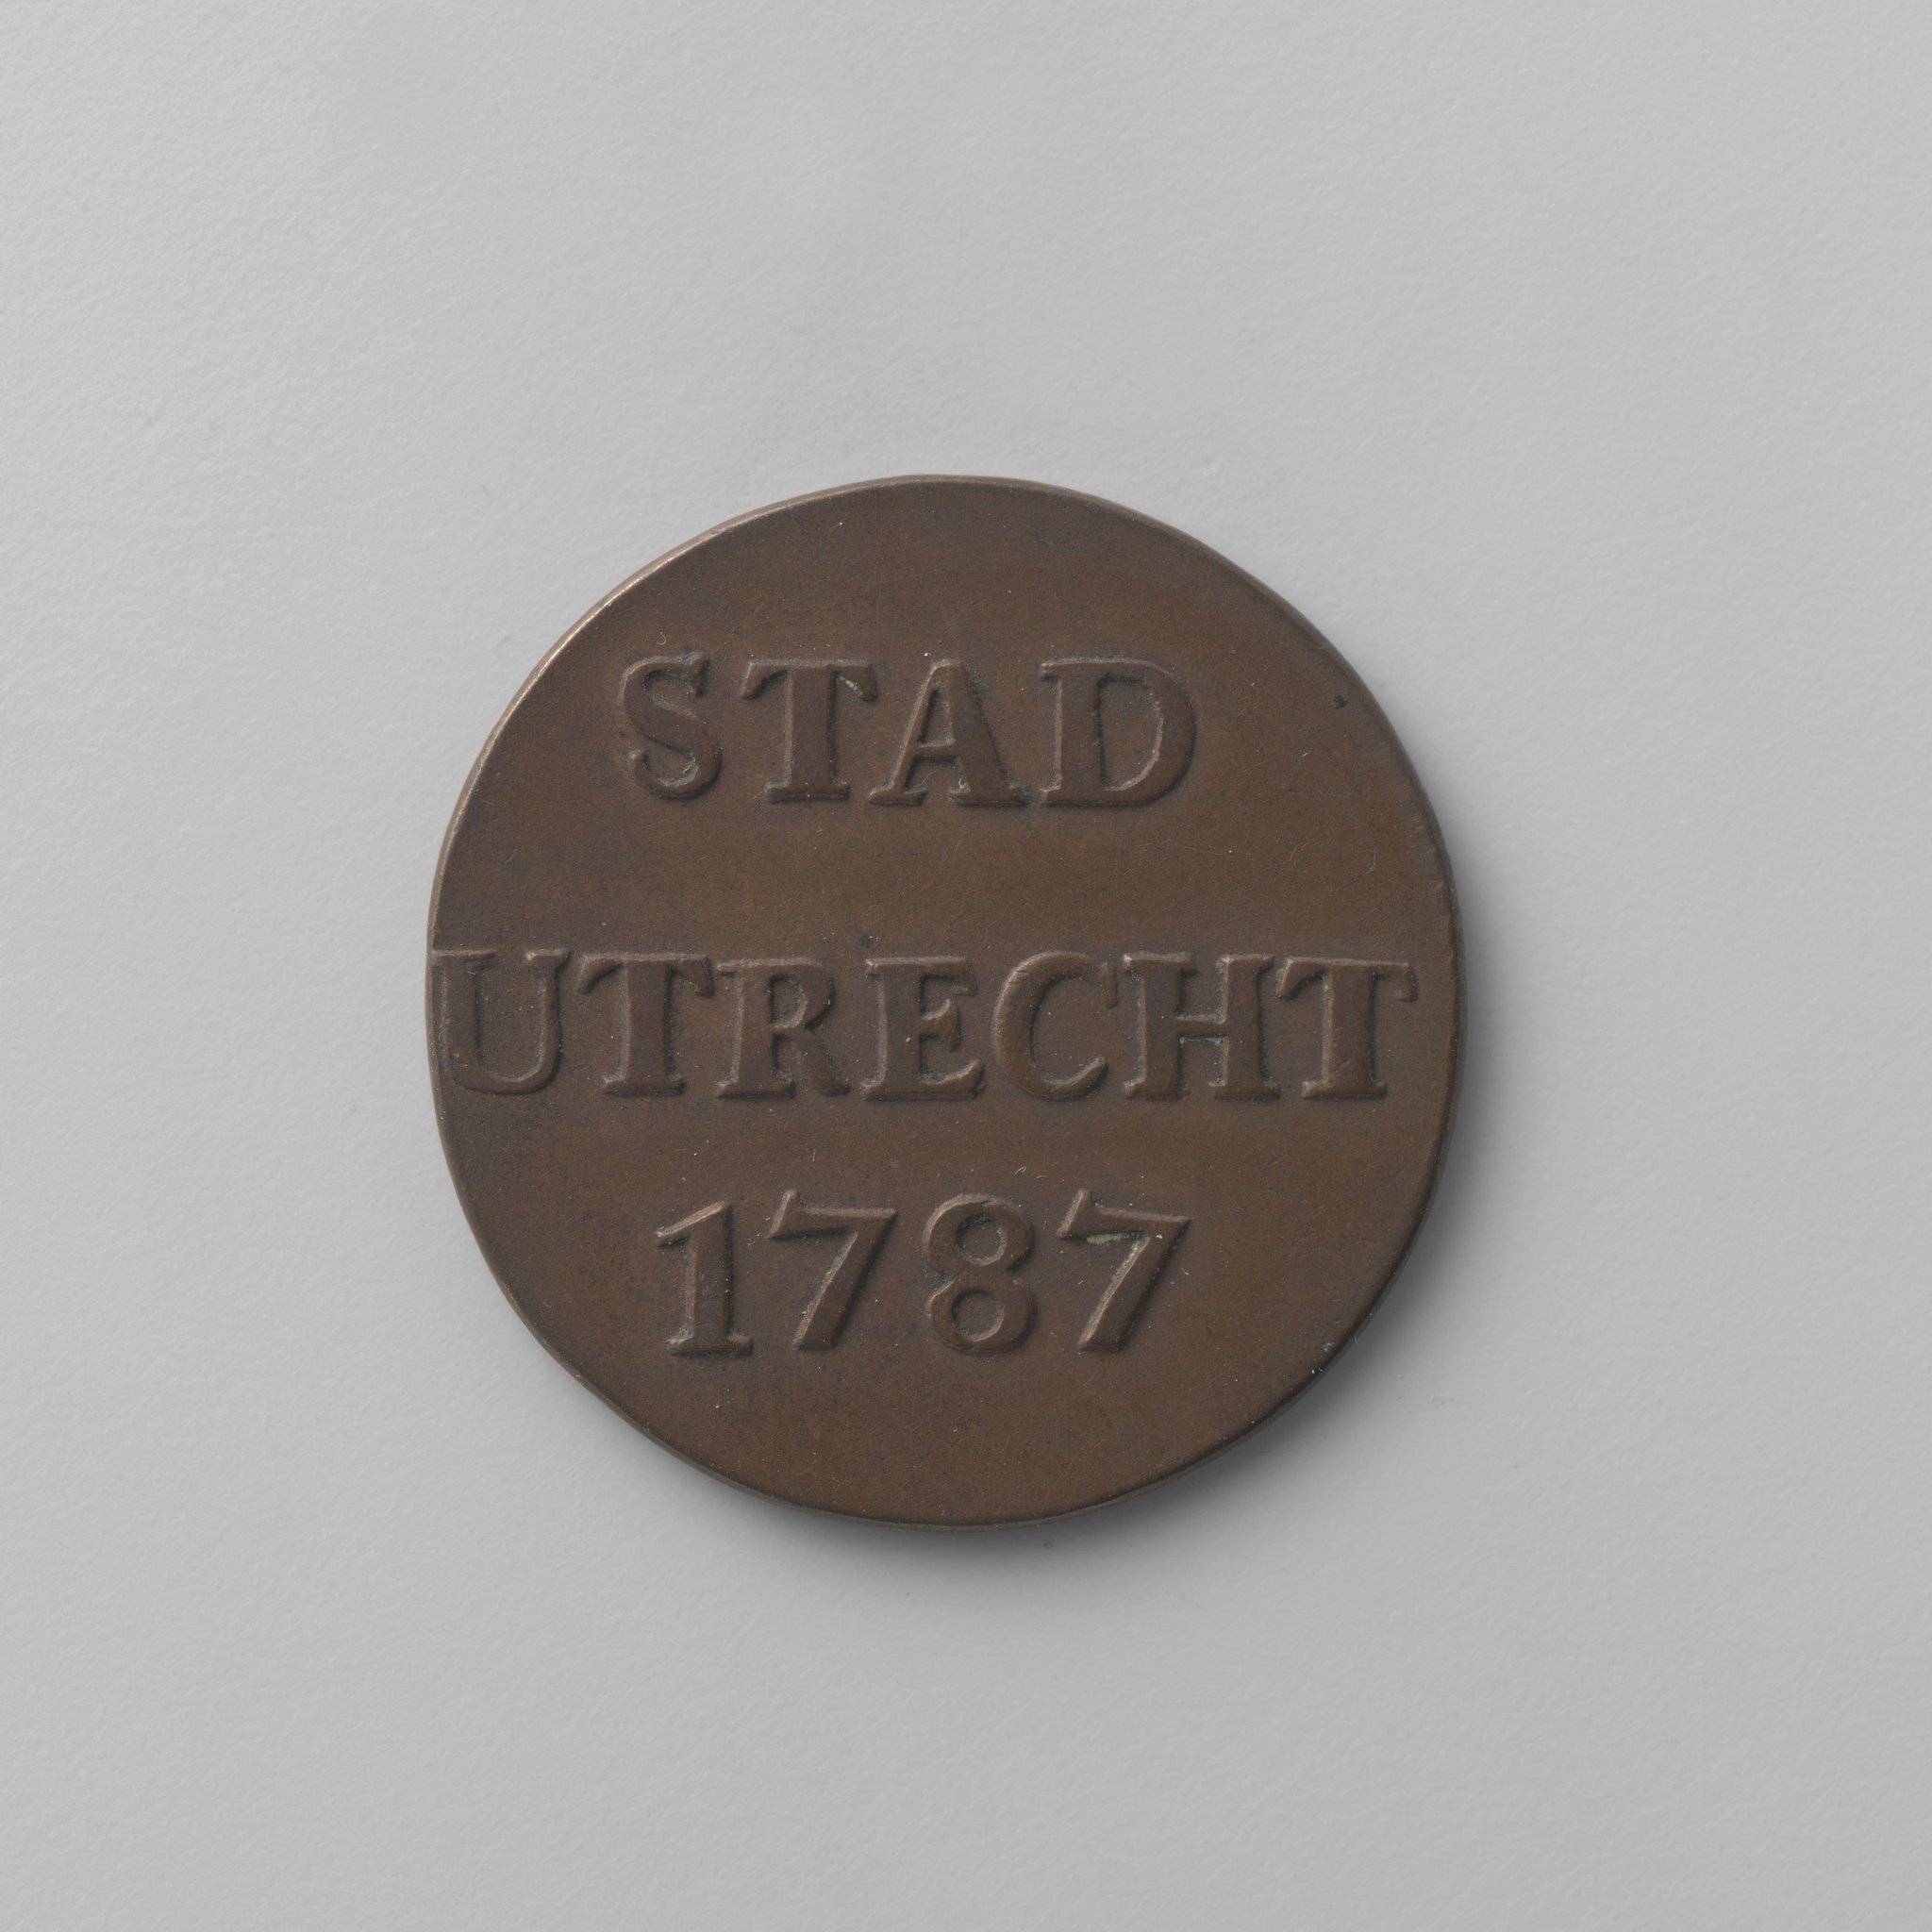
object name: coin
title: Duit van de stad Utrecht, 1787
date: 1787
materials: copper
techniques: striking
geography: utrecht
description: Koperen munt. Voorzijde: gekroond stedelijk wapenschild, gehouden door twee leeuwen met in afsnede dubbele lijn, waaronder een versierde accolade met een grote schelp. Keerzijde: opschrift in twee regels, waaronder jaartal. Jaartal met Arabische 1.